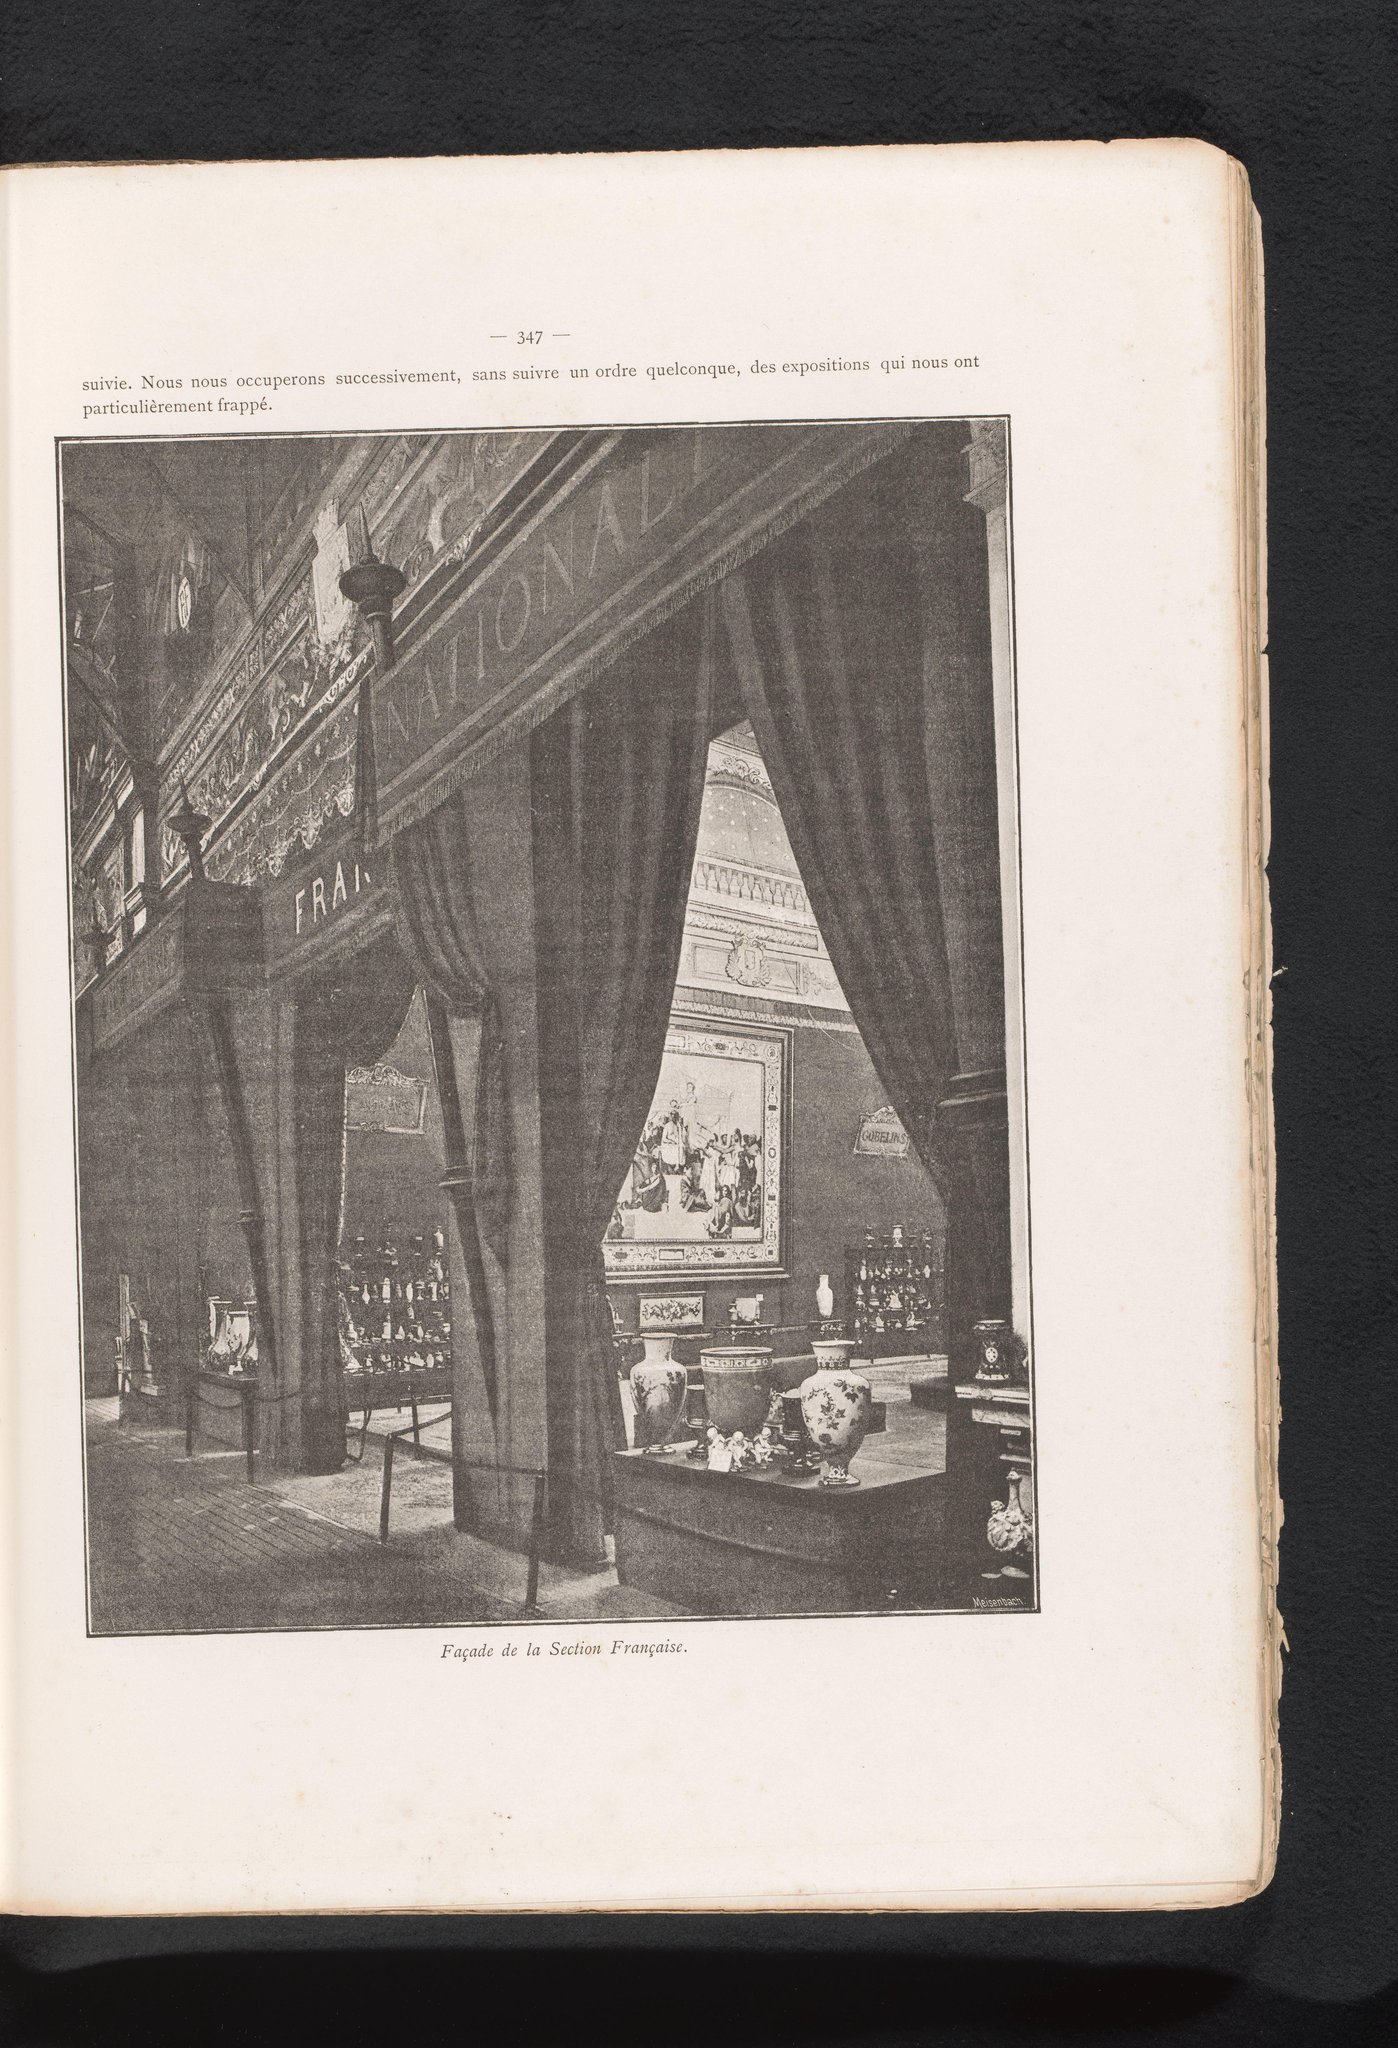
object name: page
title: Façade de la Section Française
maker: Anonymous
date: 1880-1885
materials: paper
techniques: autotype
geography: antwerp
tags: world fair, world exhibition, antwerp